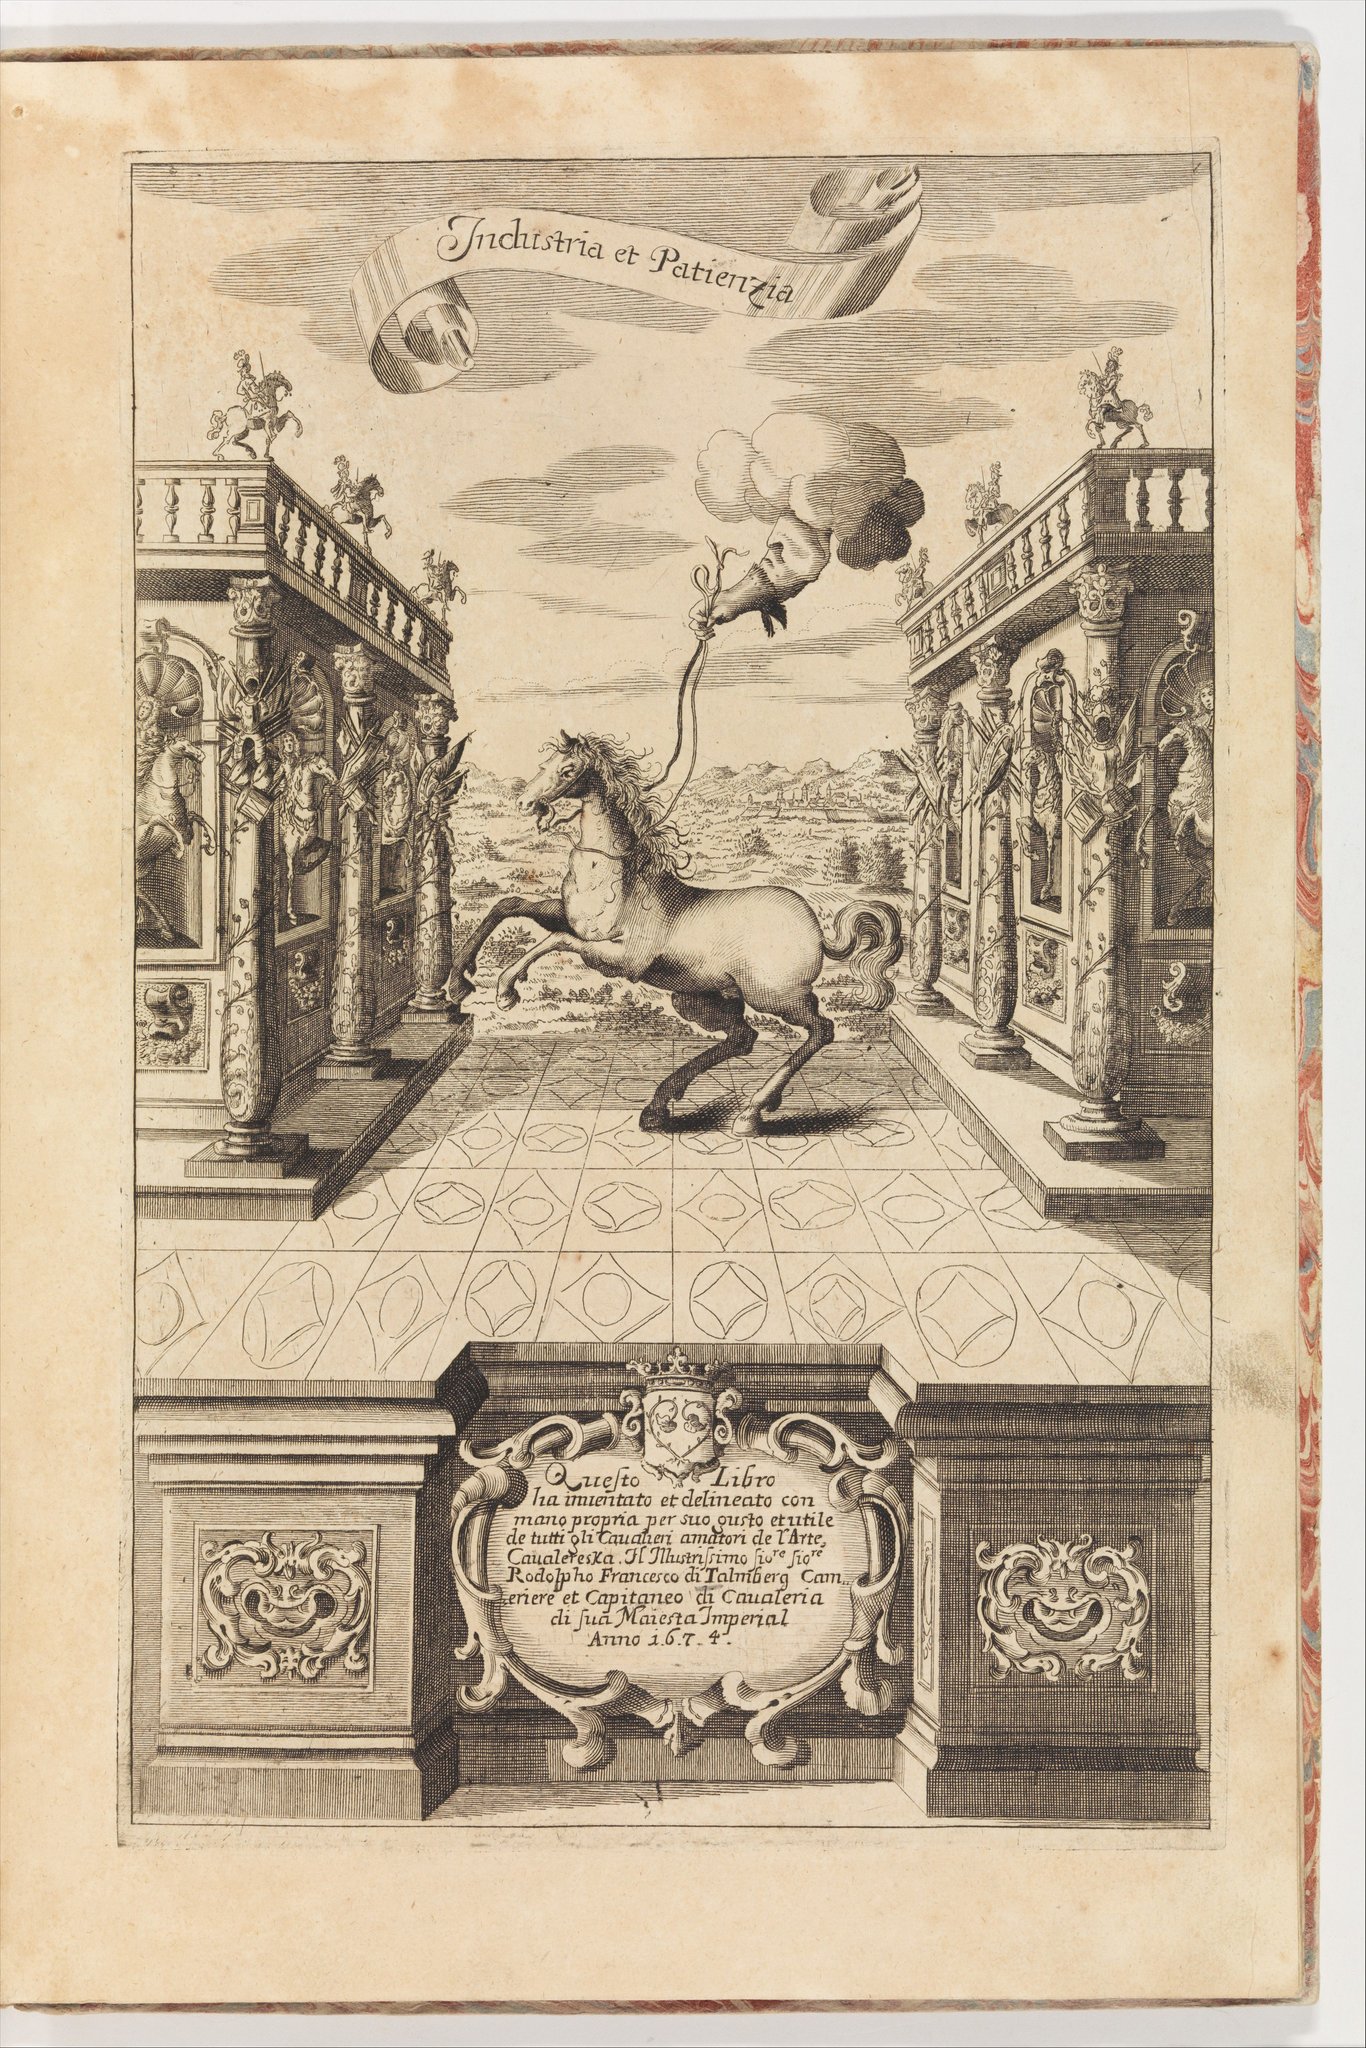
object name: album of bit design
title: Album of Bit Designs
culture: bohemian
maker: rudolf franz ferdinand von talmberg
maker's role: designer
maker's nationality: bohemian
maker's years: 1620-1727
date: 1674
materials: ink, paper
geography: bohemia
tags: ornament